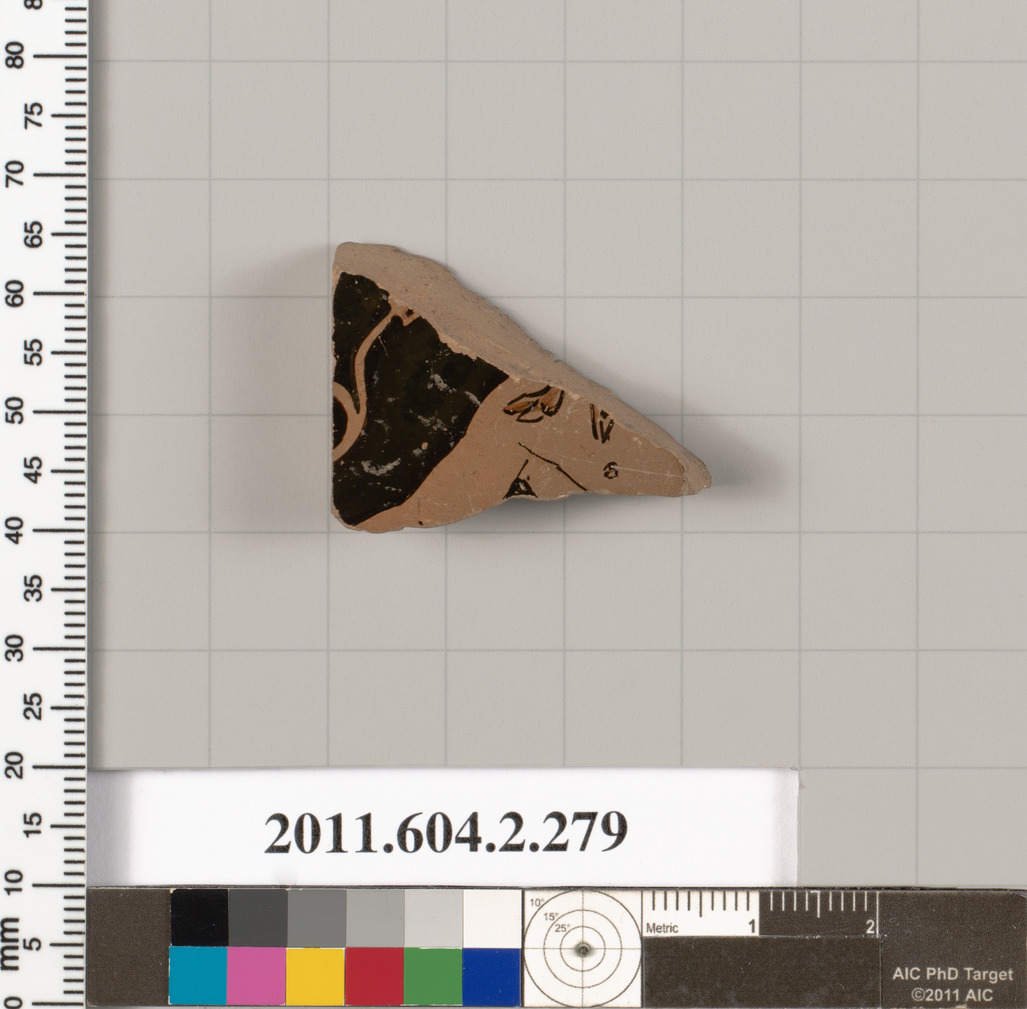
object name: volute krater fragment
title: Terracotta fragment of a volute-krater (bowl for mixing wine and water)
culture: greek, attic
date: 500-476 BCE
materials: terracotta